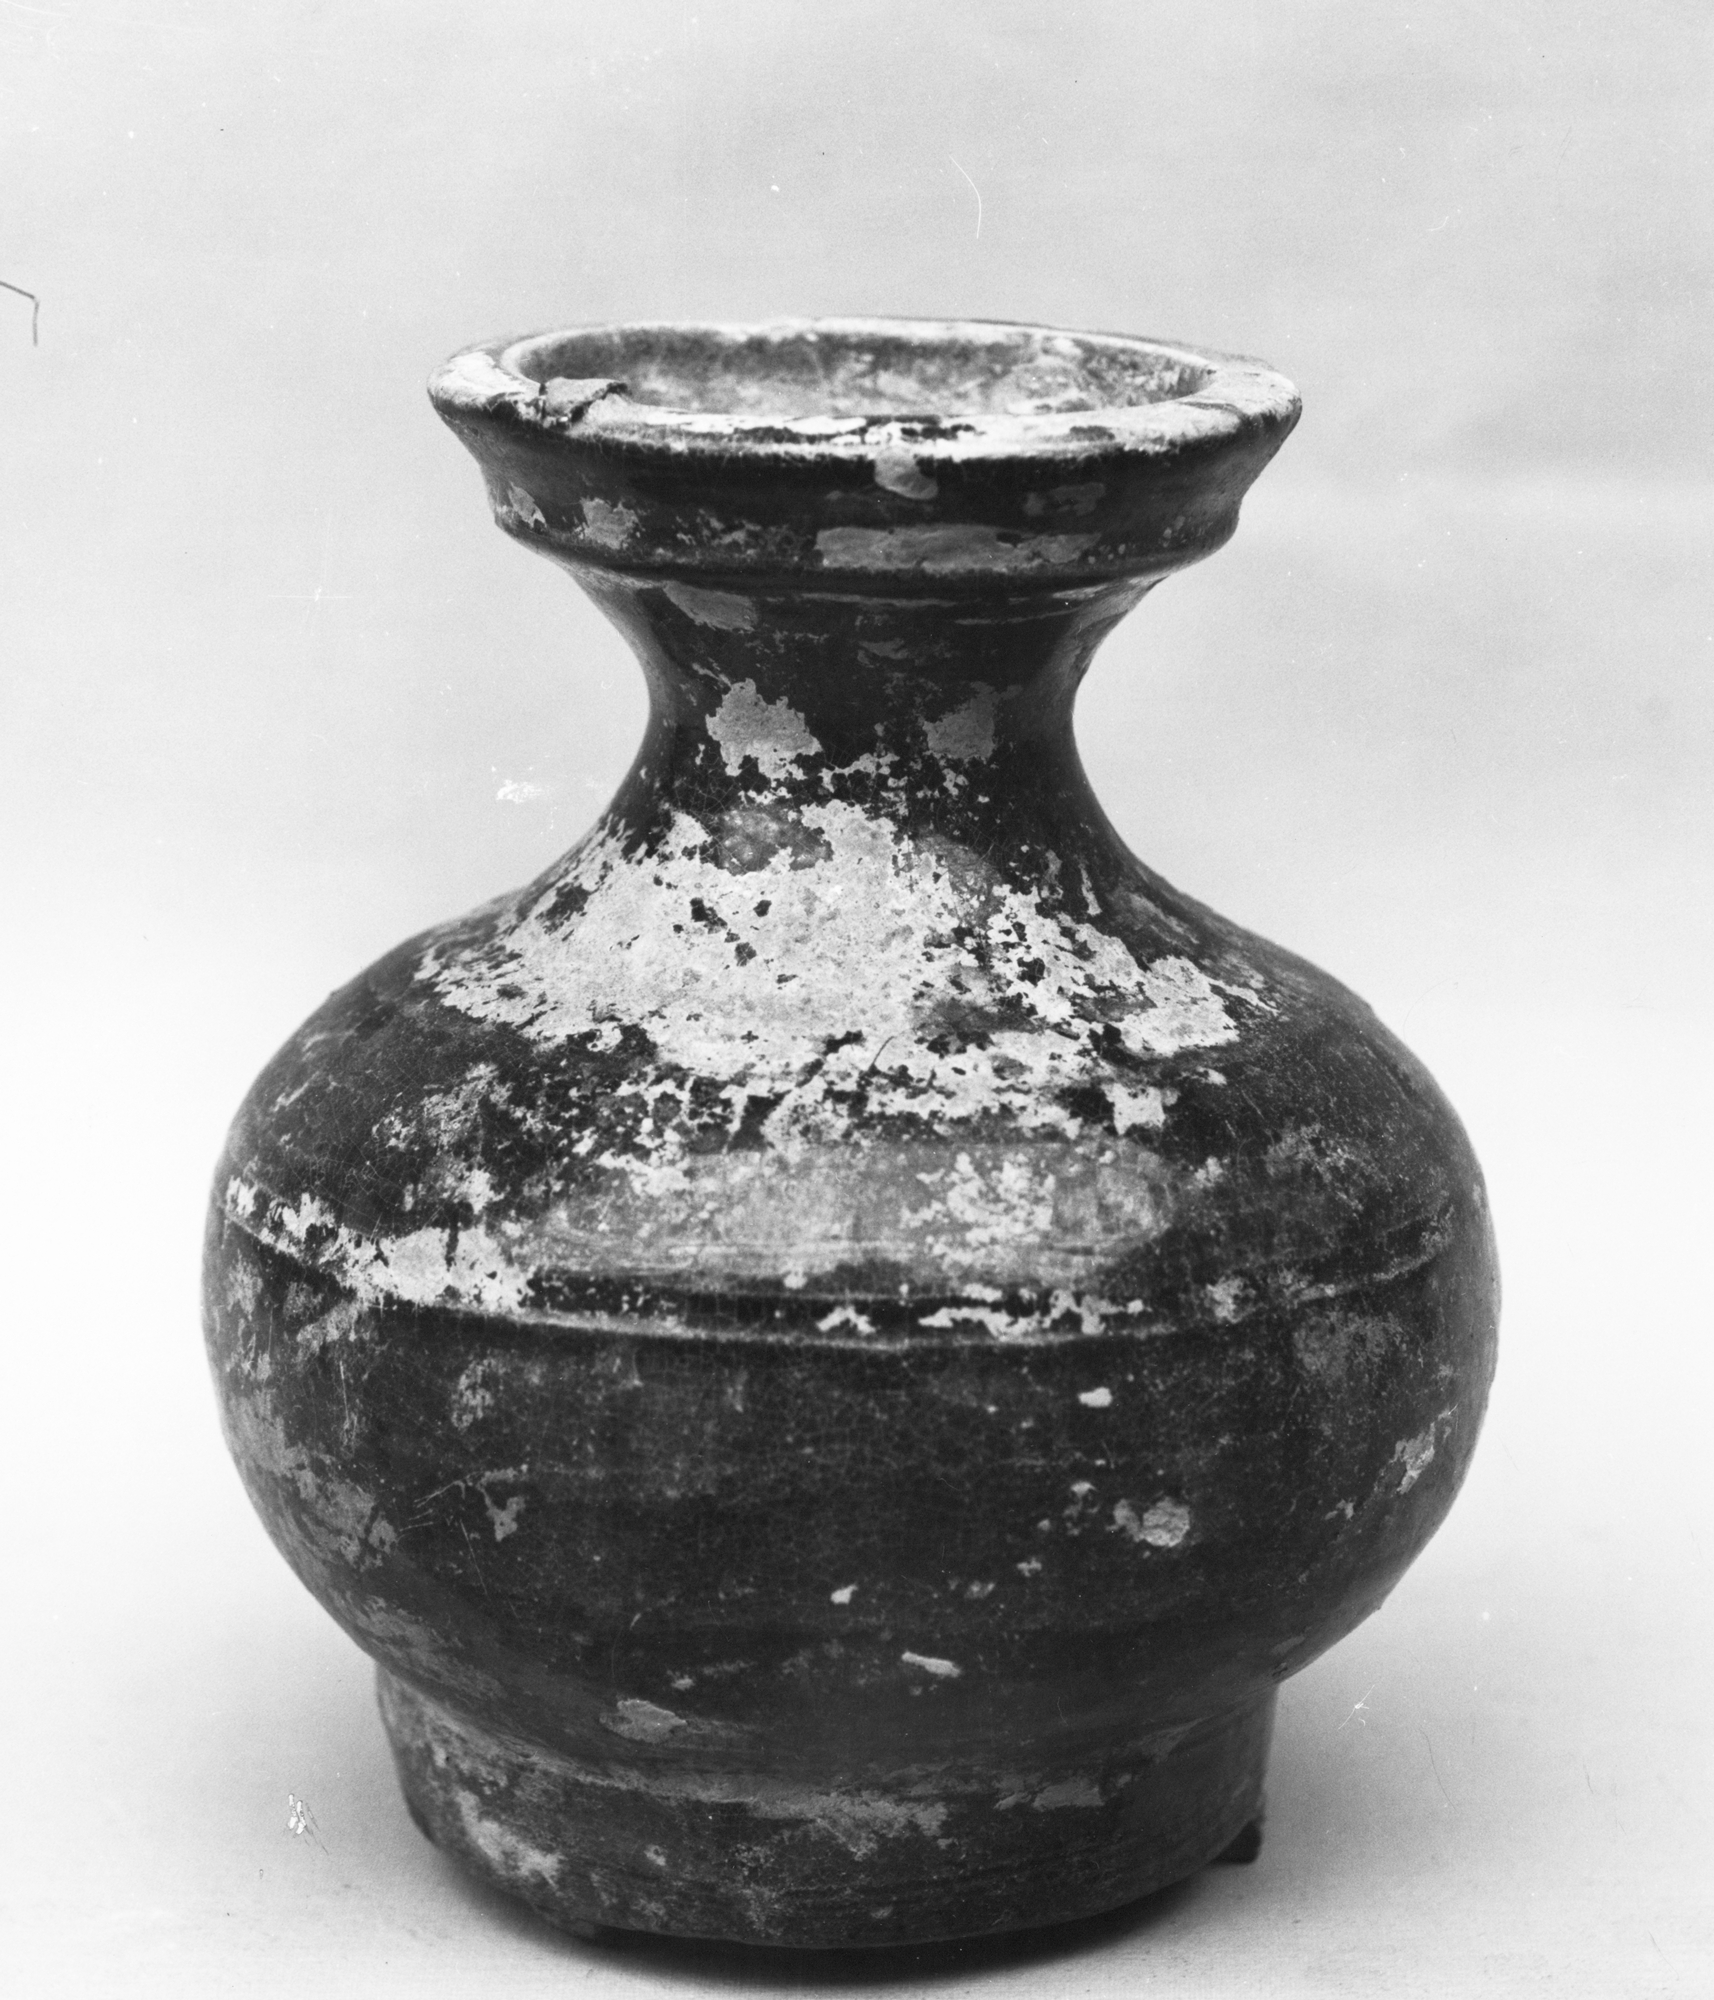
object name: vase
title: Pair of Vases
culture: chinese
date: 206 BCE-220 CE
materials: pottery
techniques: glazing